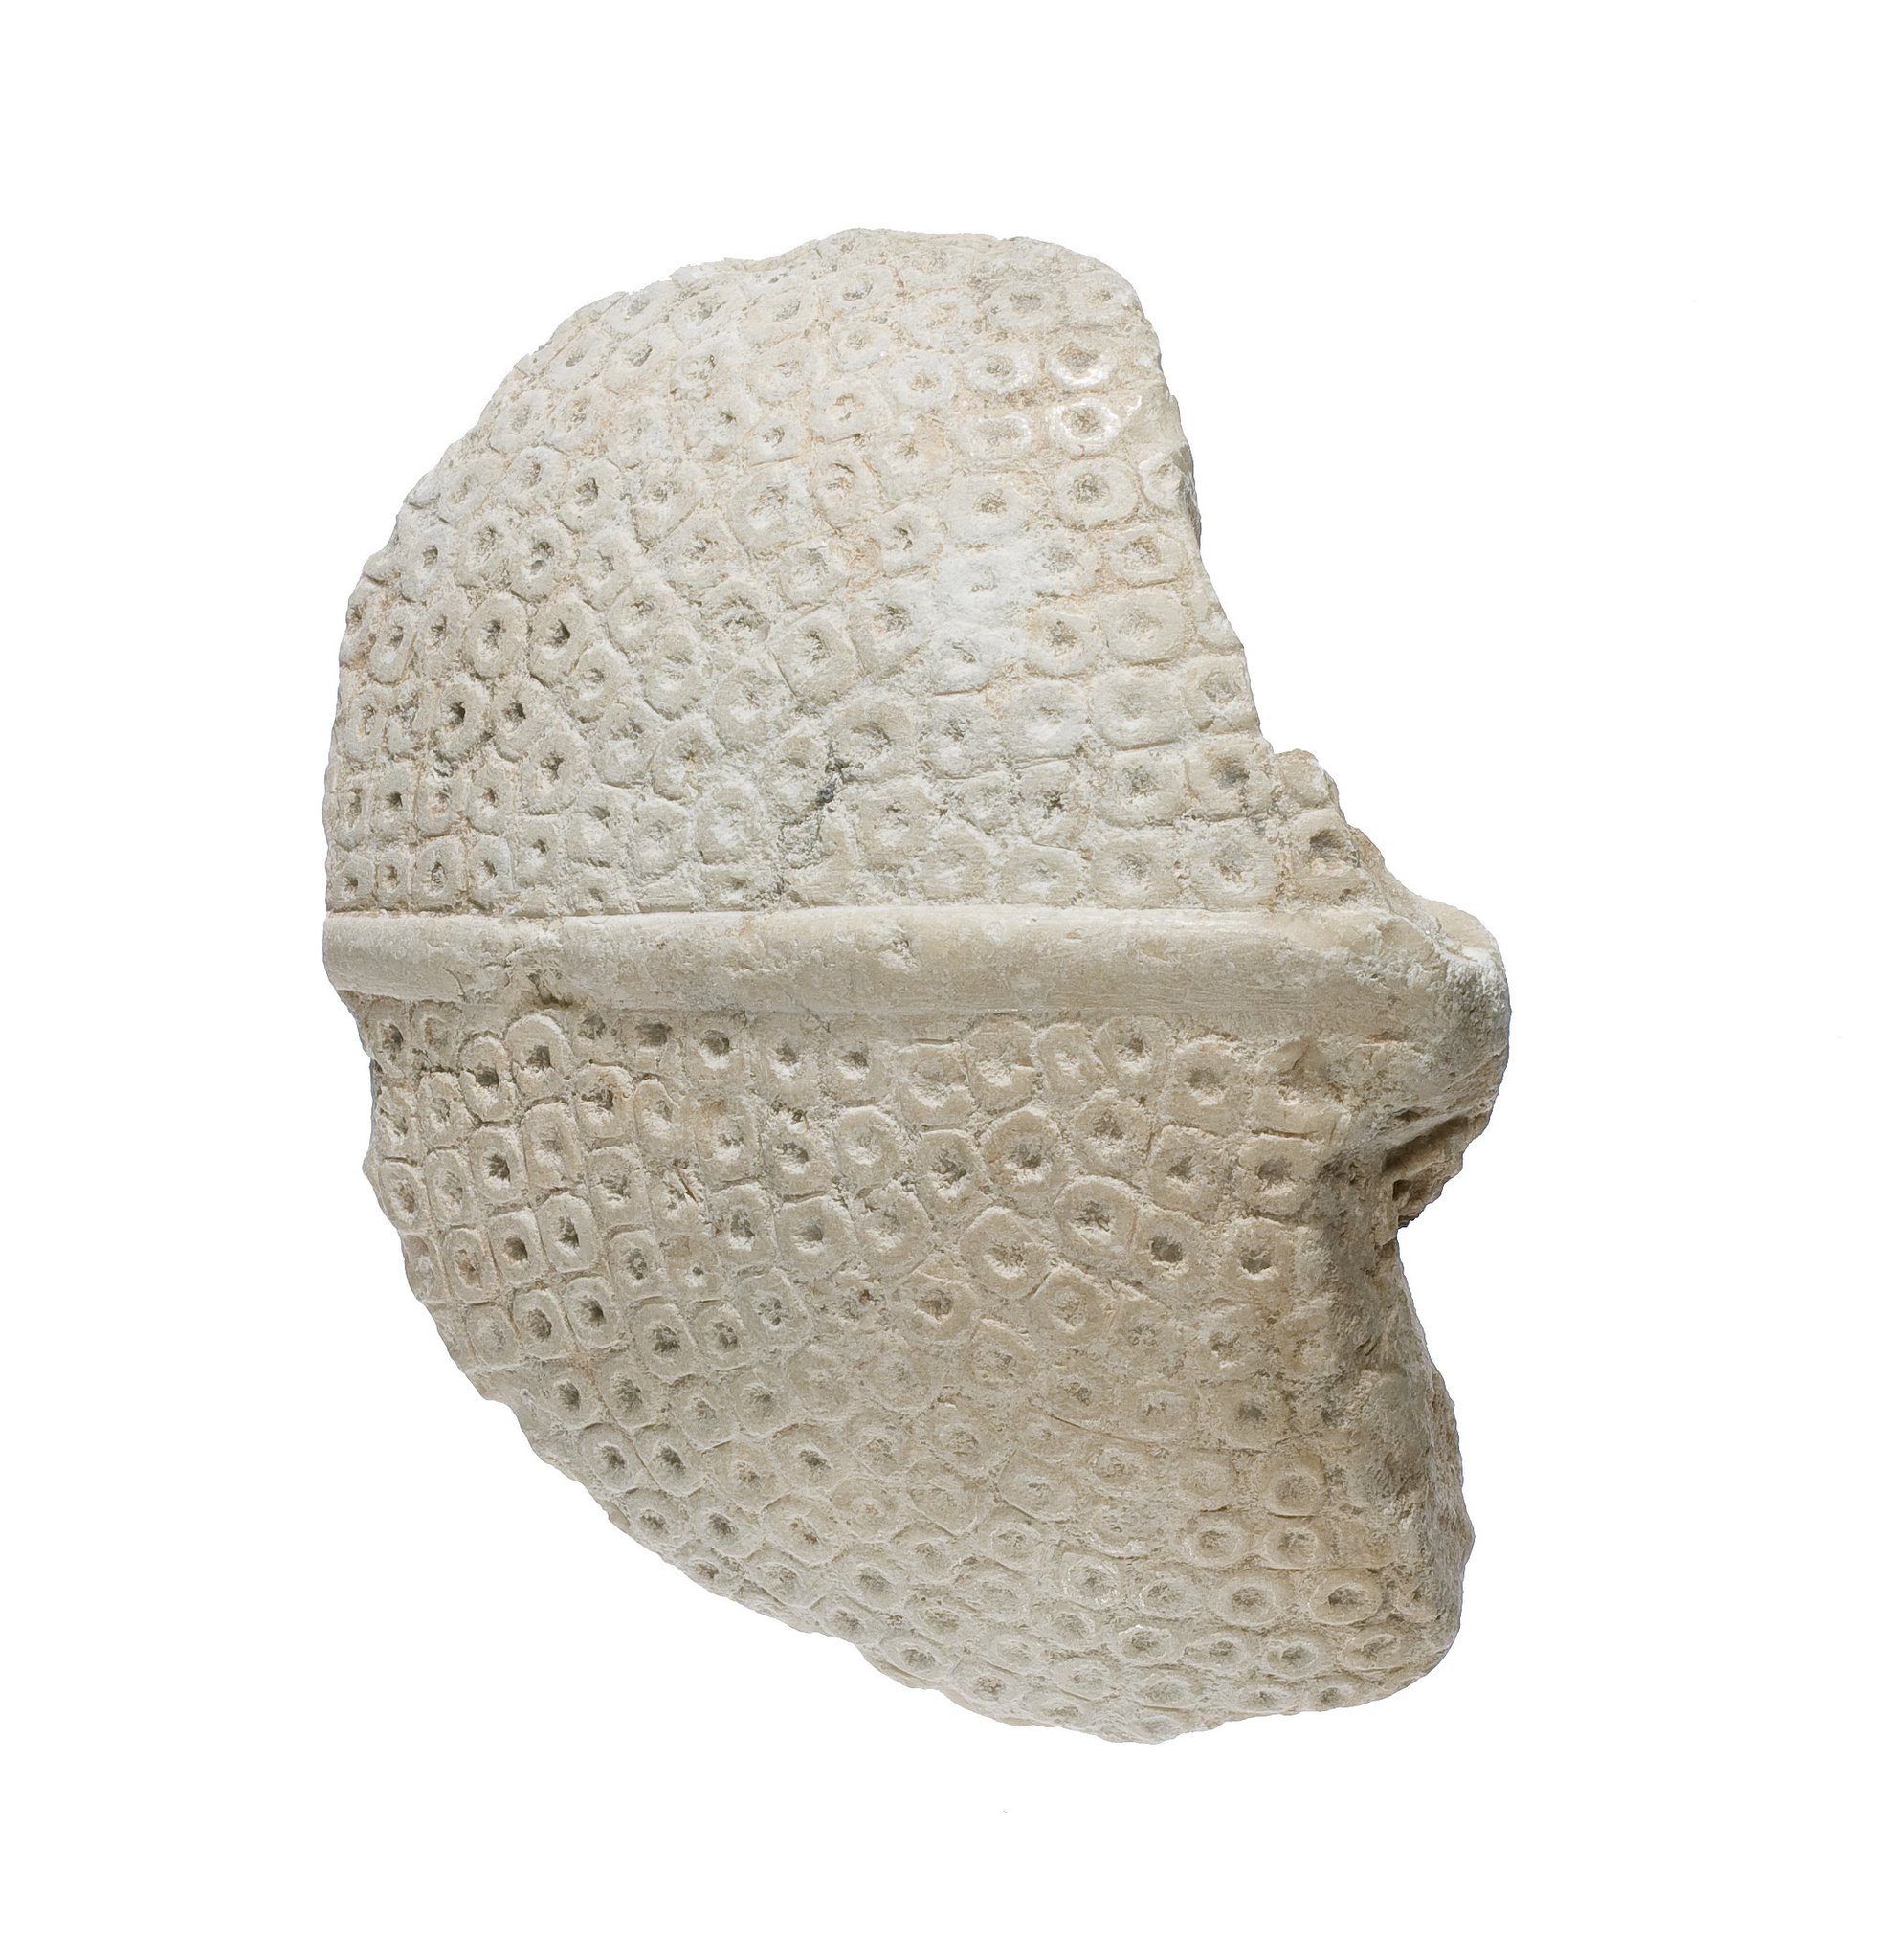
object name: head of akhenaten, blue crown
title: Blue crown from head of Akhenaten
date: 1353-1336 BCE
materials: limestone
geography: egypt